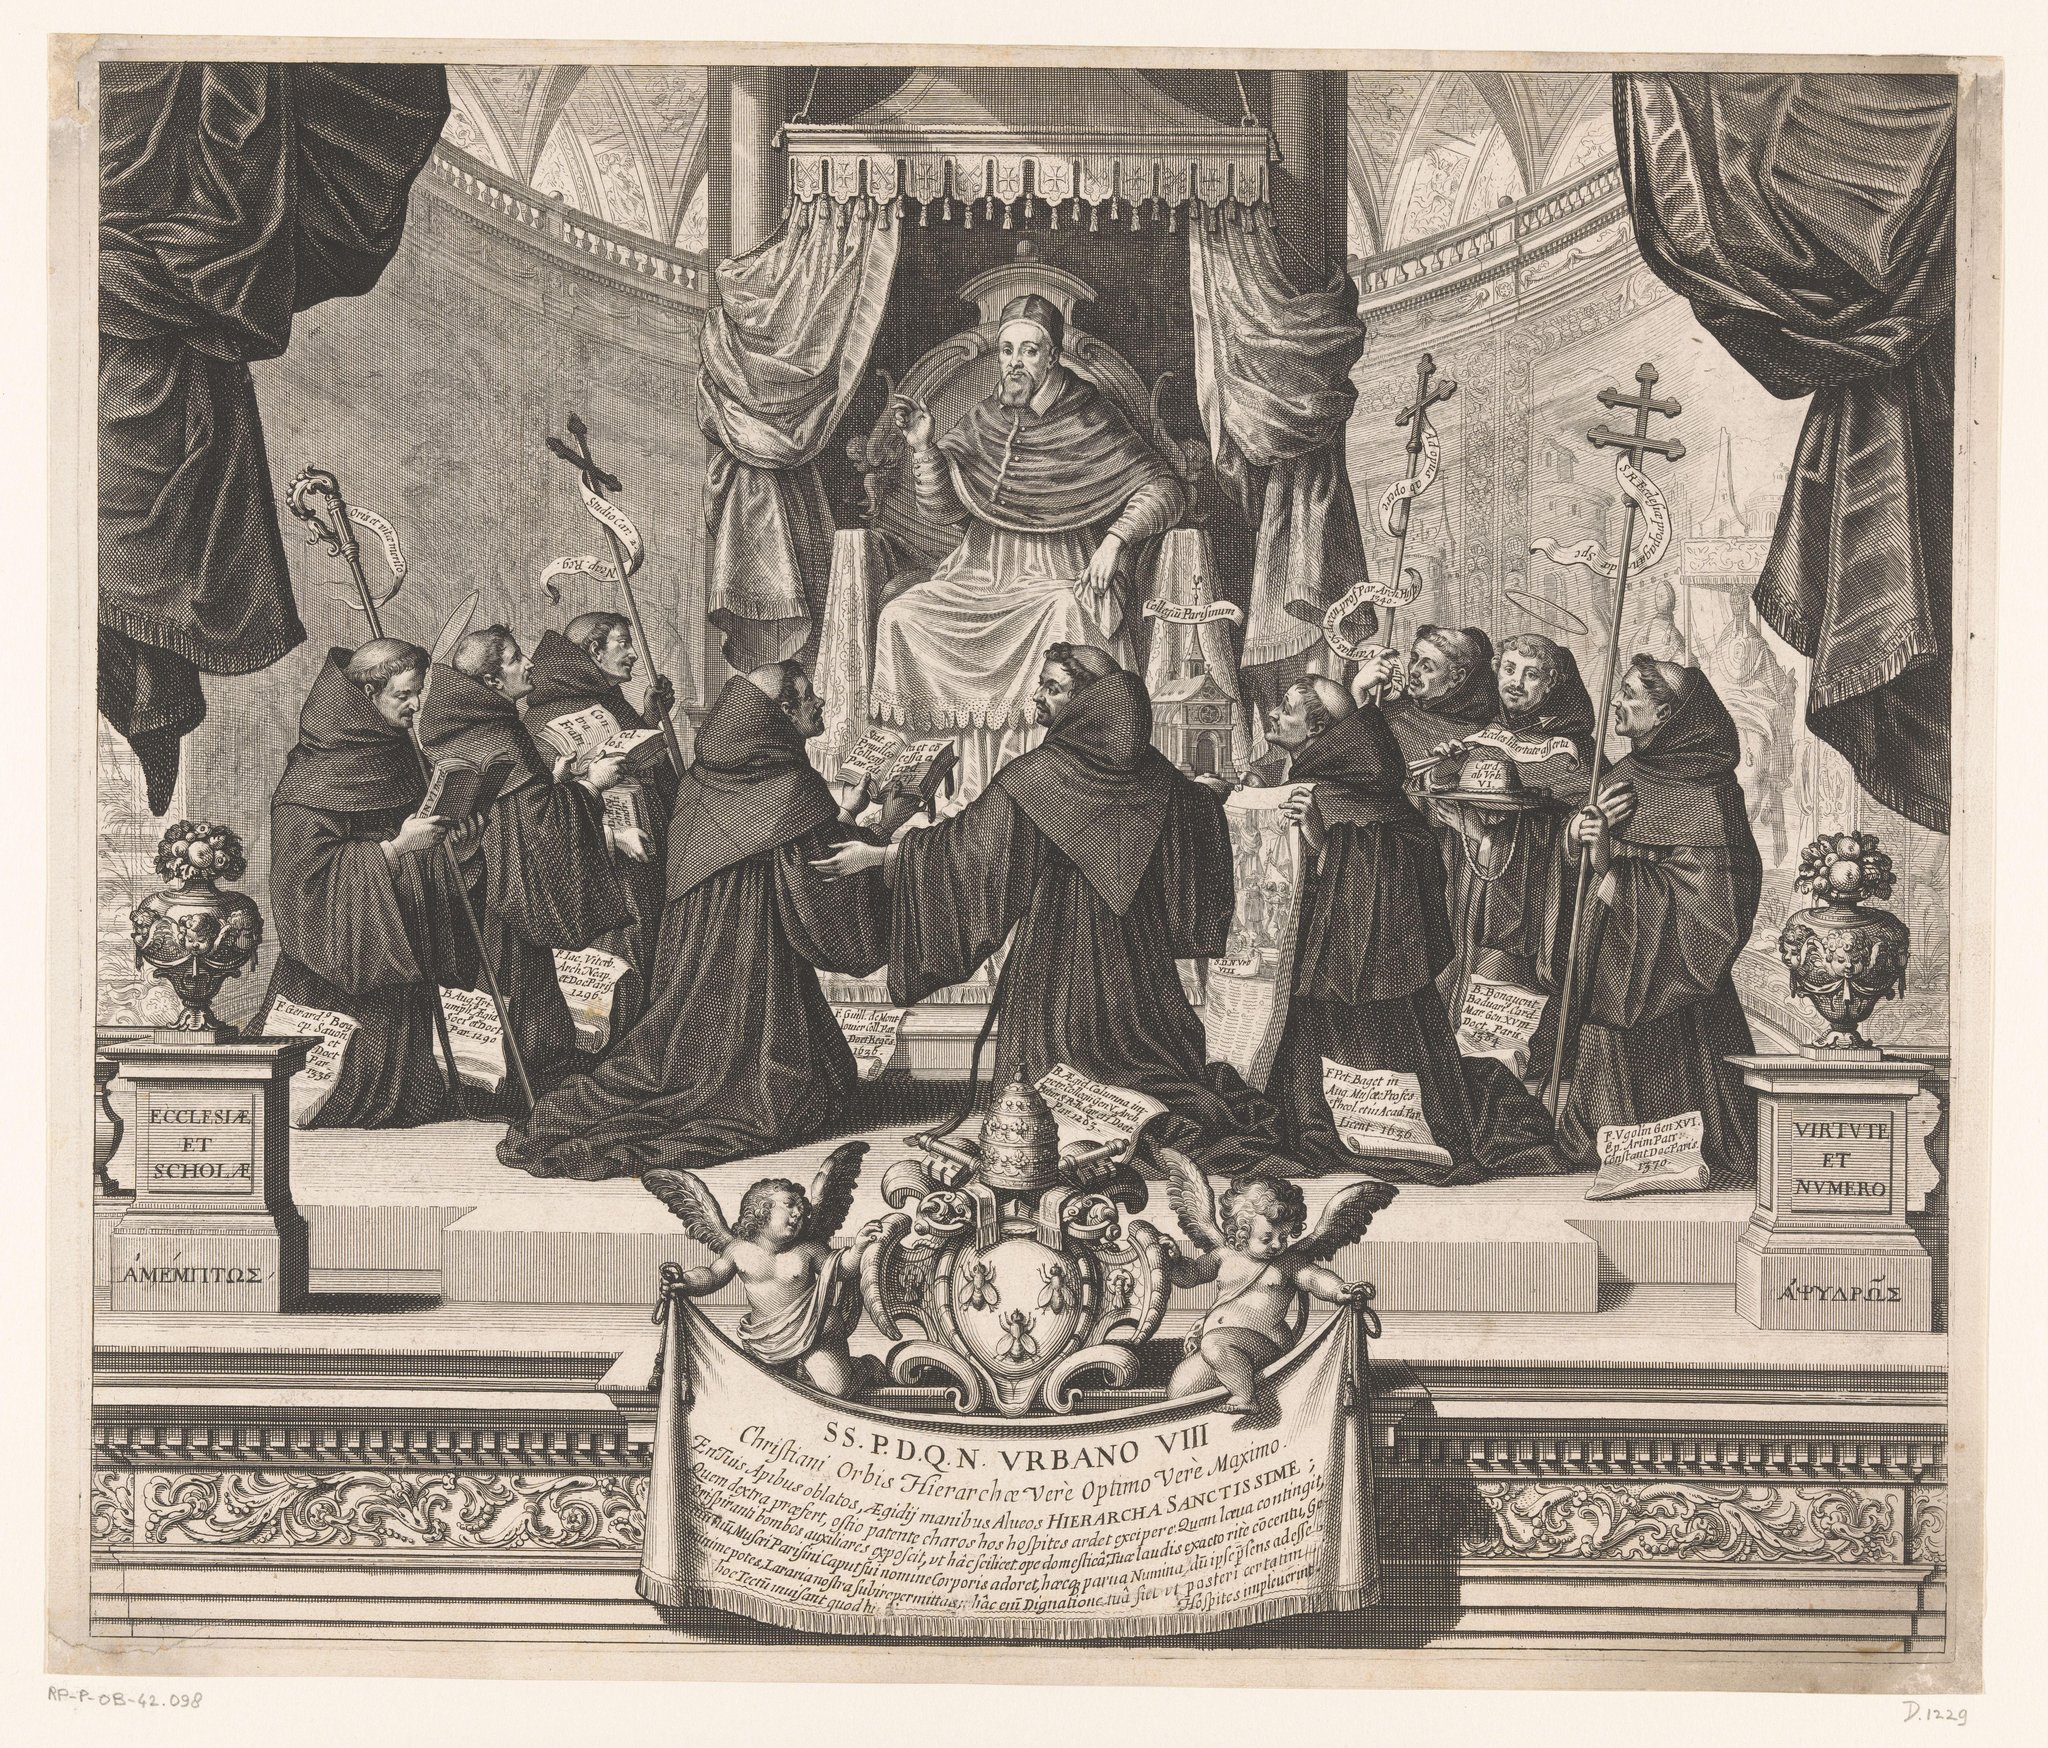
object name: print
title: Paus Urbanus VIII zegent knielende geestelijken voor hem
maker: abraham bosse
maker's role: draughtsman, print maker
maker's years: 1602-1676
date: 1636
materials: paper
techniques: engraving, etching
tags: clergyman, urbanus viii, historical persons, pope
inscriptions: collector's mark: Lugt 240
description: Betreft de bovenkant van een prent, bestaande uit twee delen, voor de theologische these van Pierre Baget, c. juni 1636.